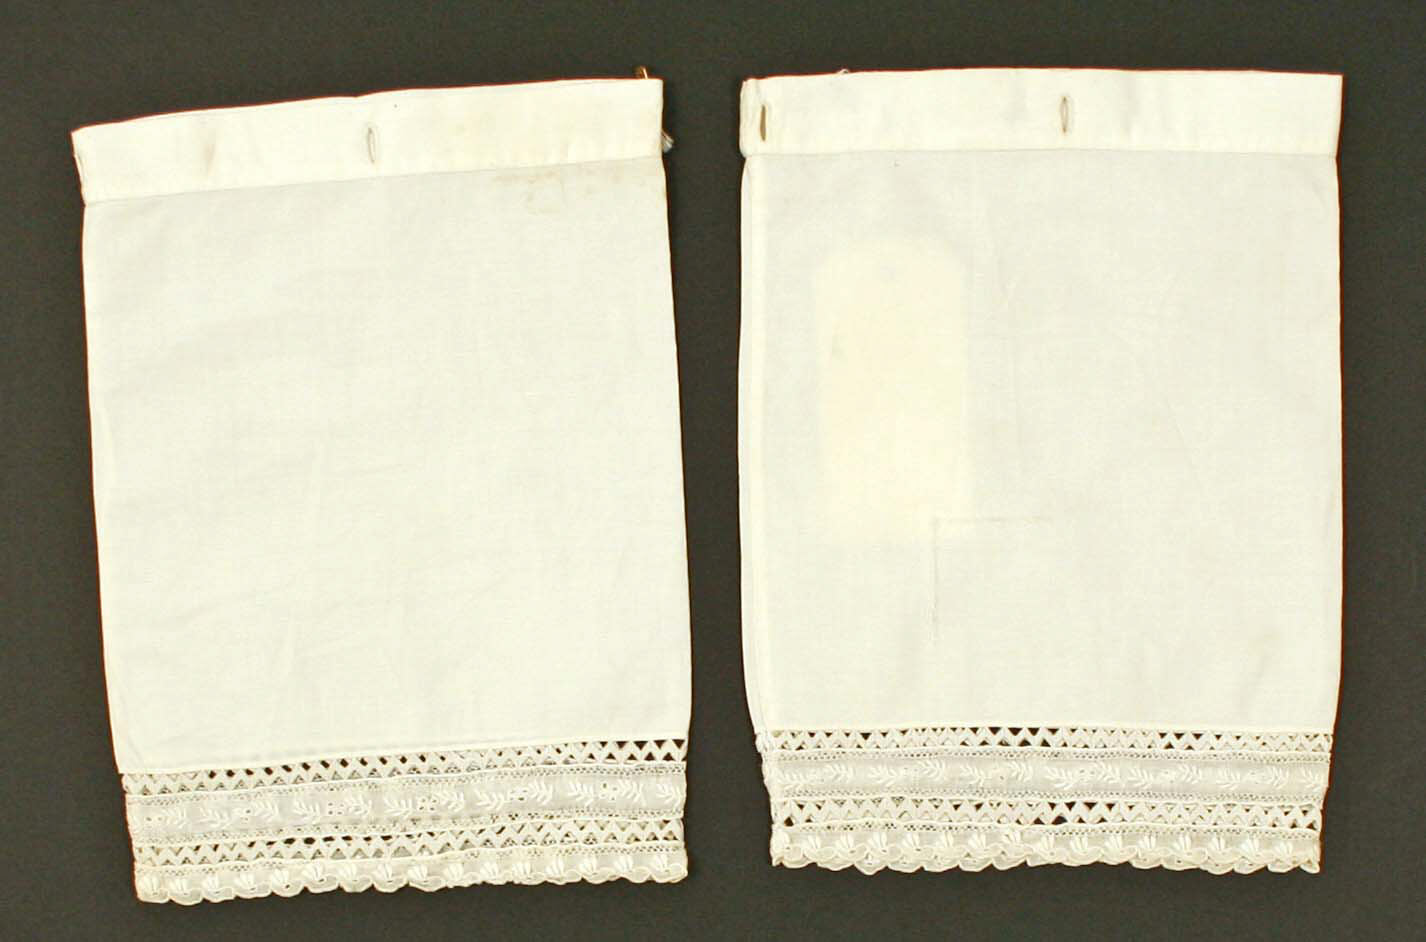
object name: pantaloon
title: Pantaloons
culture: american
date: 1838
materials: linen